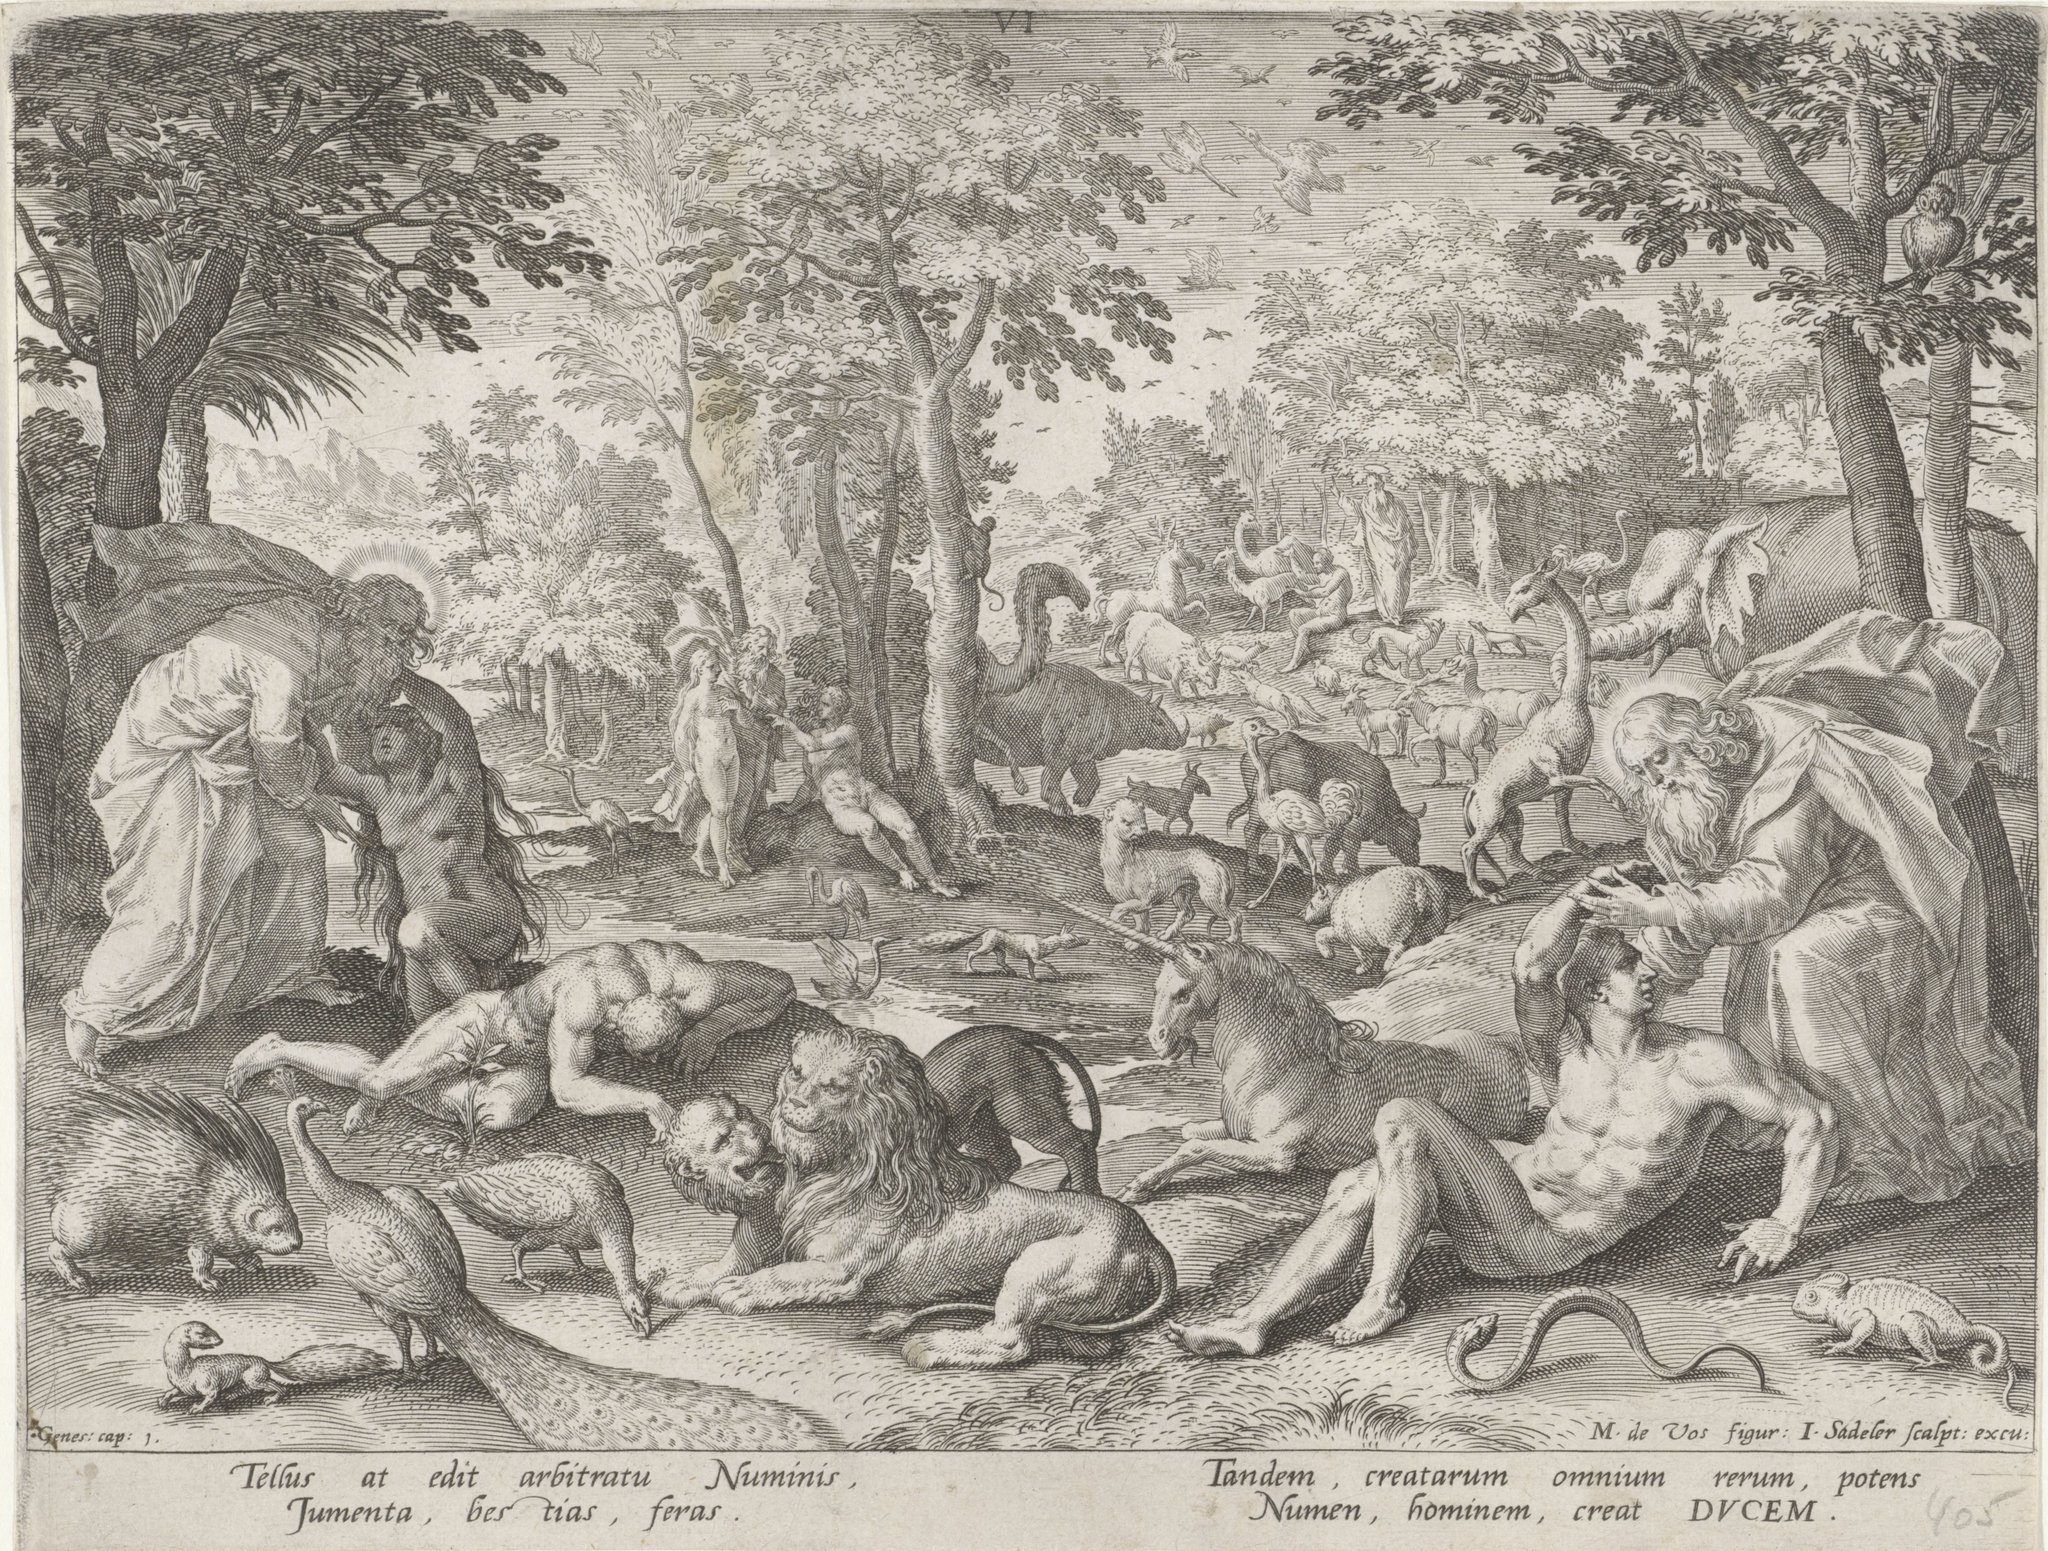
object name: print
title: Schepping van de wereld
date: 1588-1600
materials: paper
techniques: engraving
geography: munich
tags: creation of man; the garden of eden (genesis 1:26 - 2), unicorn, animals, god the father as bearded old man, usually with crown or tiara or sceptre and/or globe, creation of eve, beasts of prey, predatory animals: lion, creation of land-animals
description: Ten midden van de dieren worden Adam en Eva door God de Vader geschapen. Rechts op de voorgrond buigt God de Vader zich over Adam; links wordt Eva uit de rib van Adam geschapen. In het midden twee leeuwen, een eenhoorn en andere dieren. In het midden op de achtergrond geeft God Eva aan Adam. Op de zesde dag van de schepping schiep God de dieren van het land en Adam en Eva. De prent heeft een Latijns onderschrift.